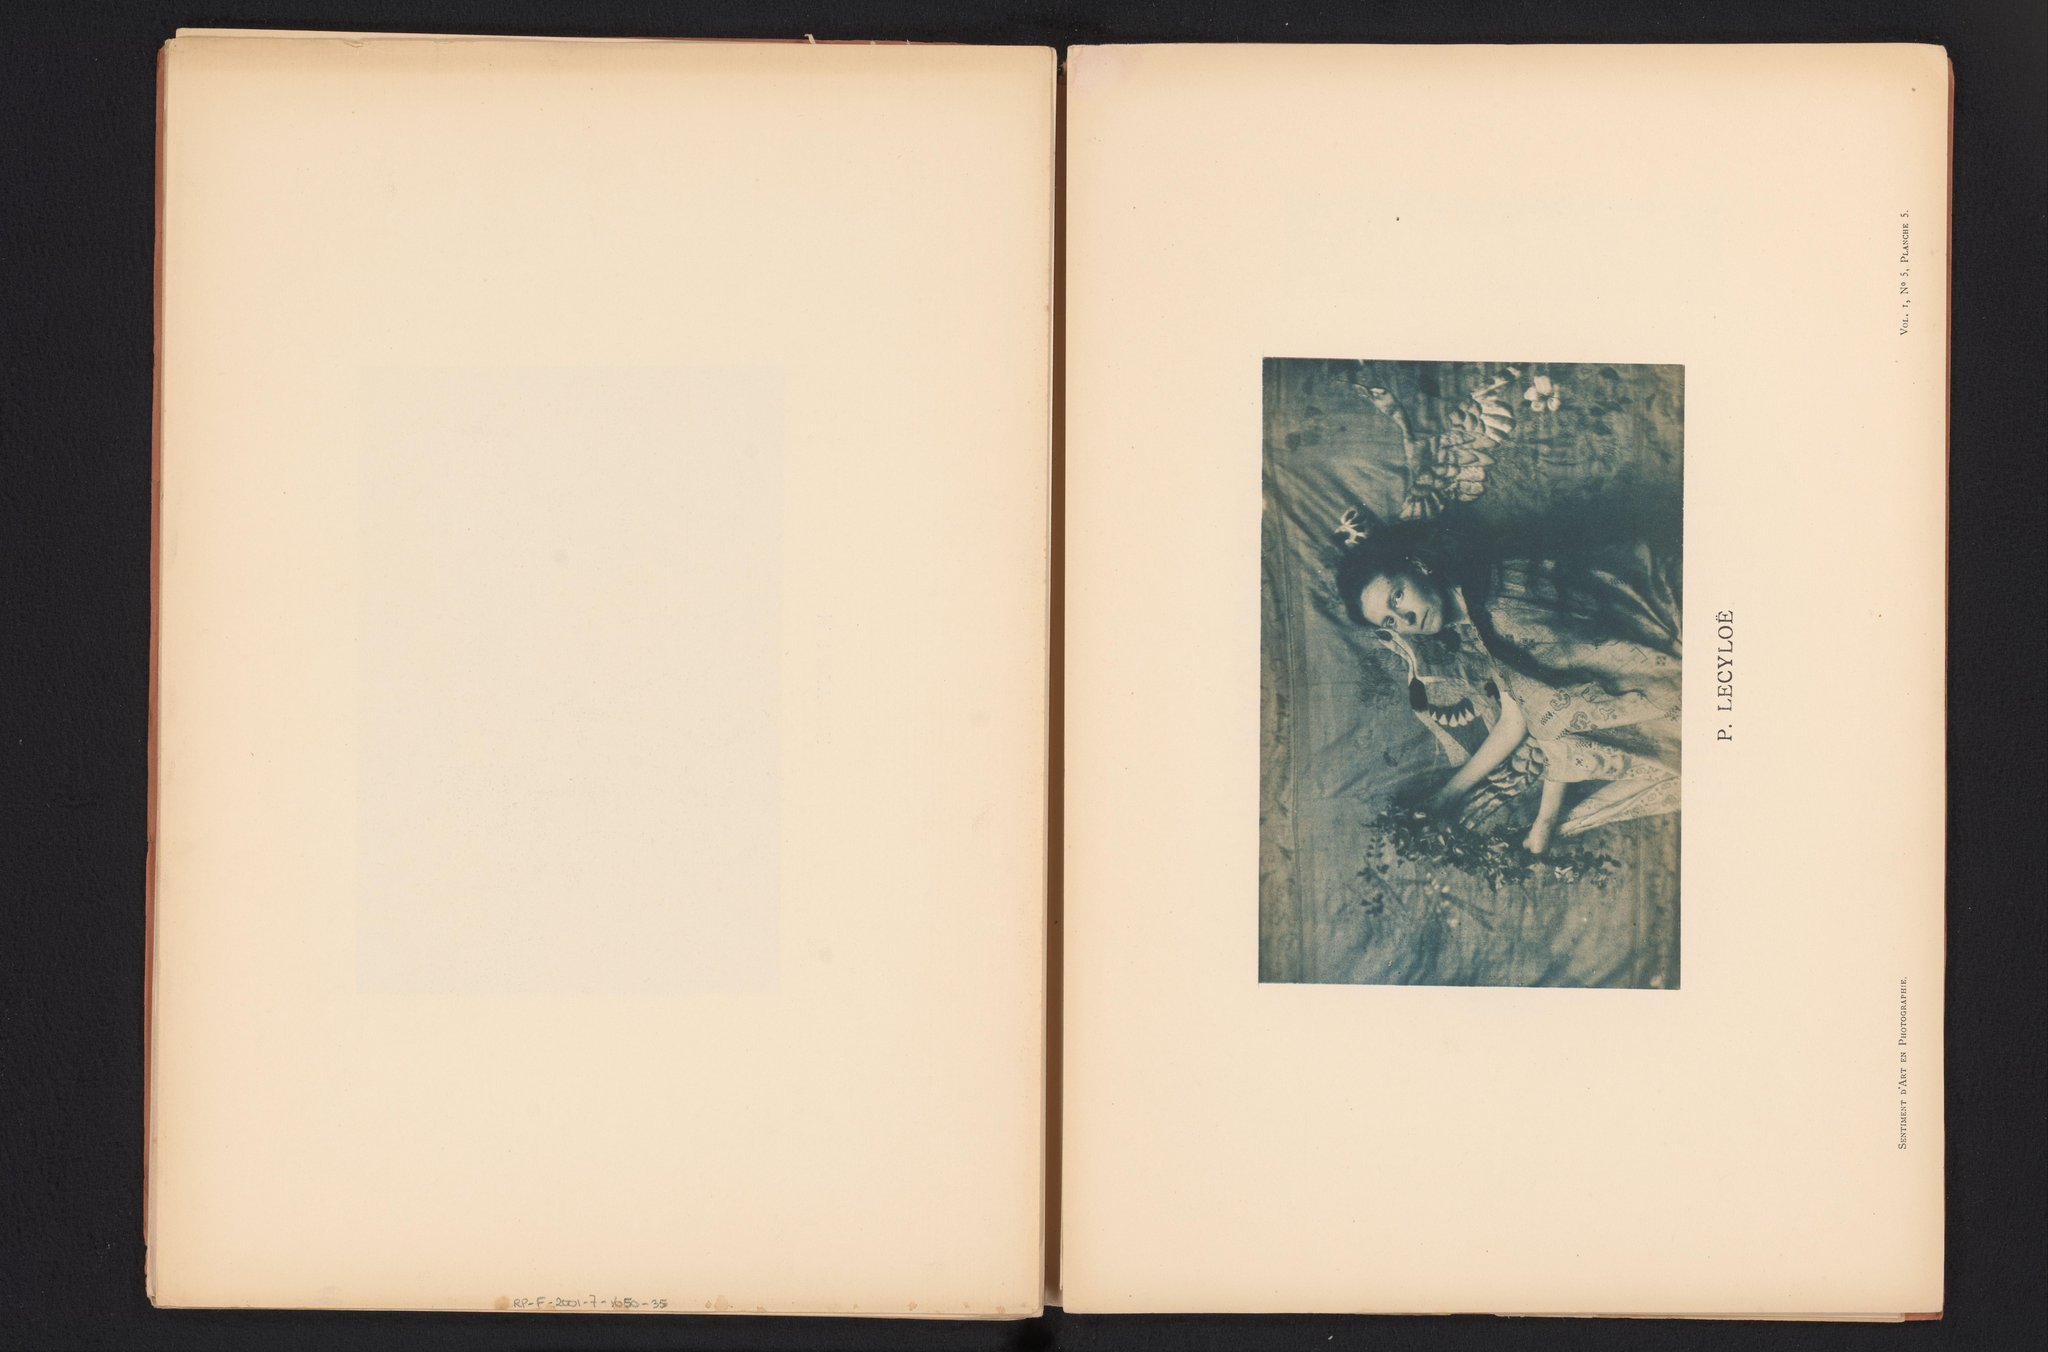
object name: photomechanical print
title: Sentiment d'Art en Photographie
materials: paper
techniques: photograph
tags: flowers, historical persons - bb - woman, tapestry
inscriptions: number: ‘Vol. 1, No 5, Planche 5.’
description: Deze prent maakt deel uit van 8 omslagen met 22 tekstbladen en 89 prenten op losse bladen in en tussen de omslagen.